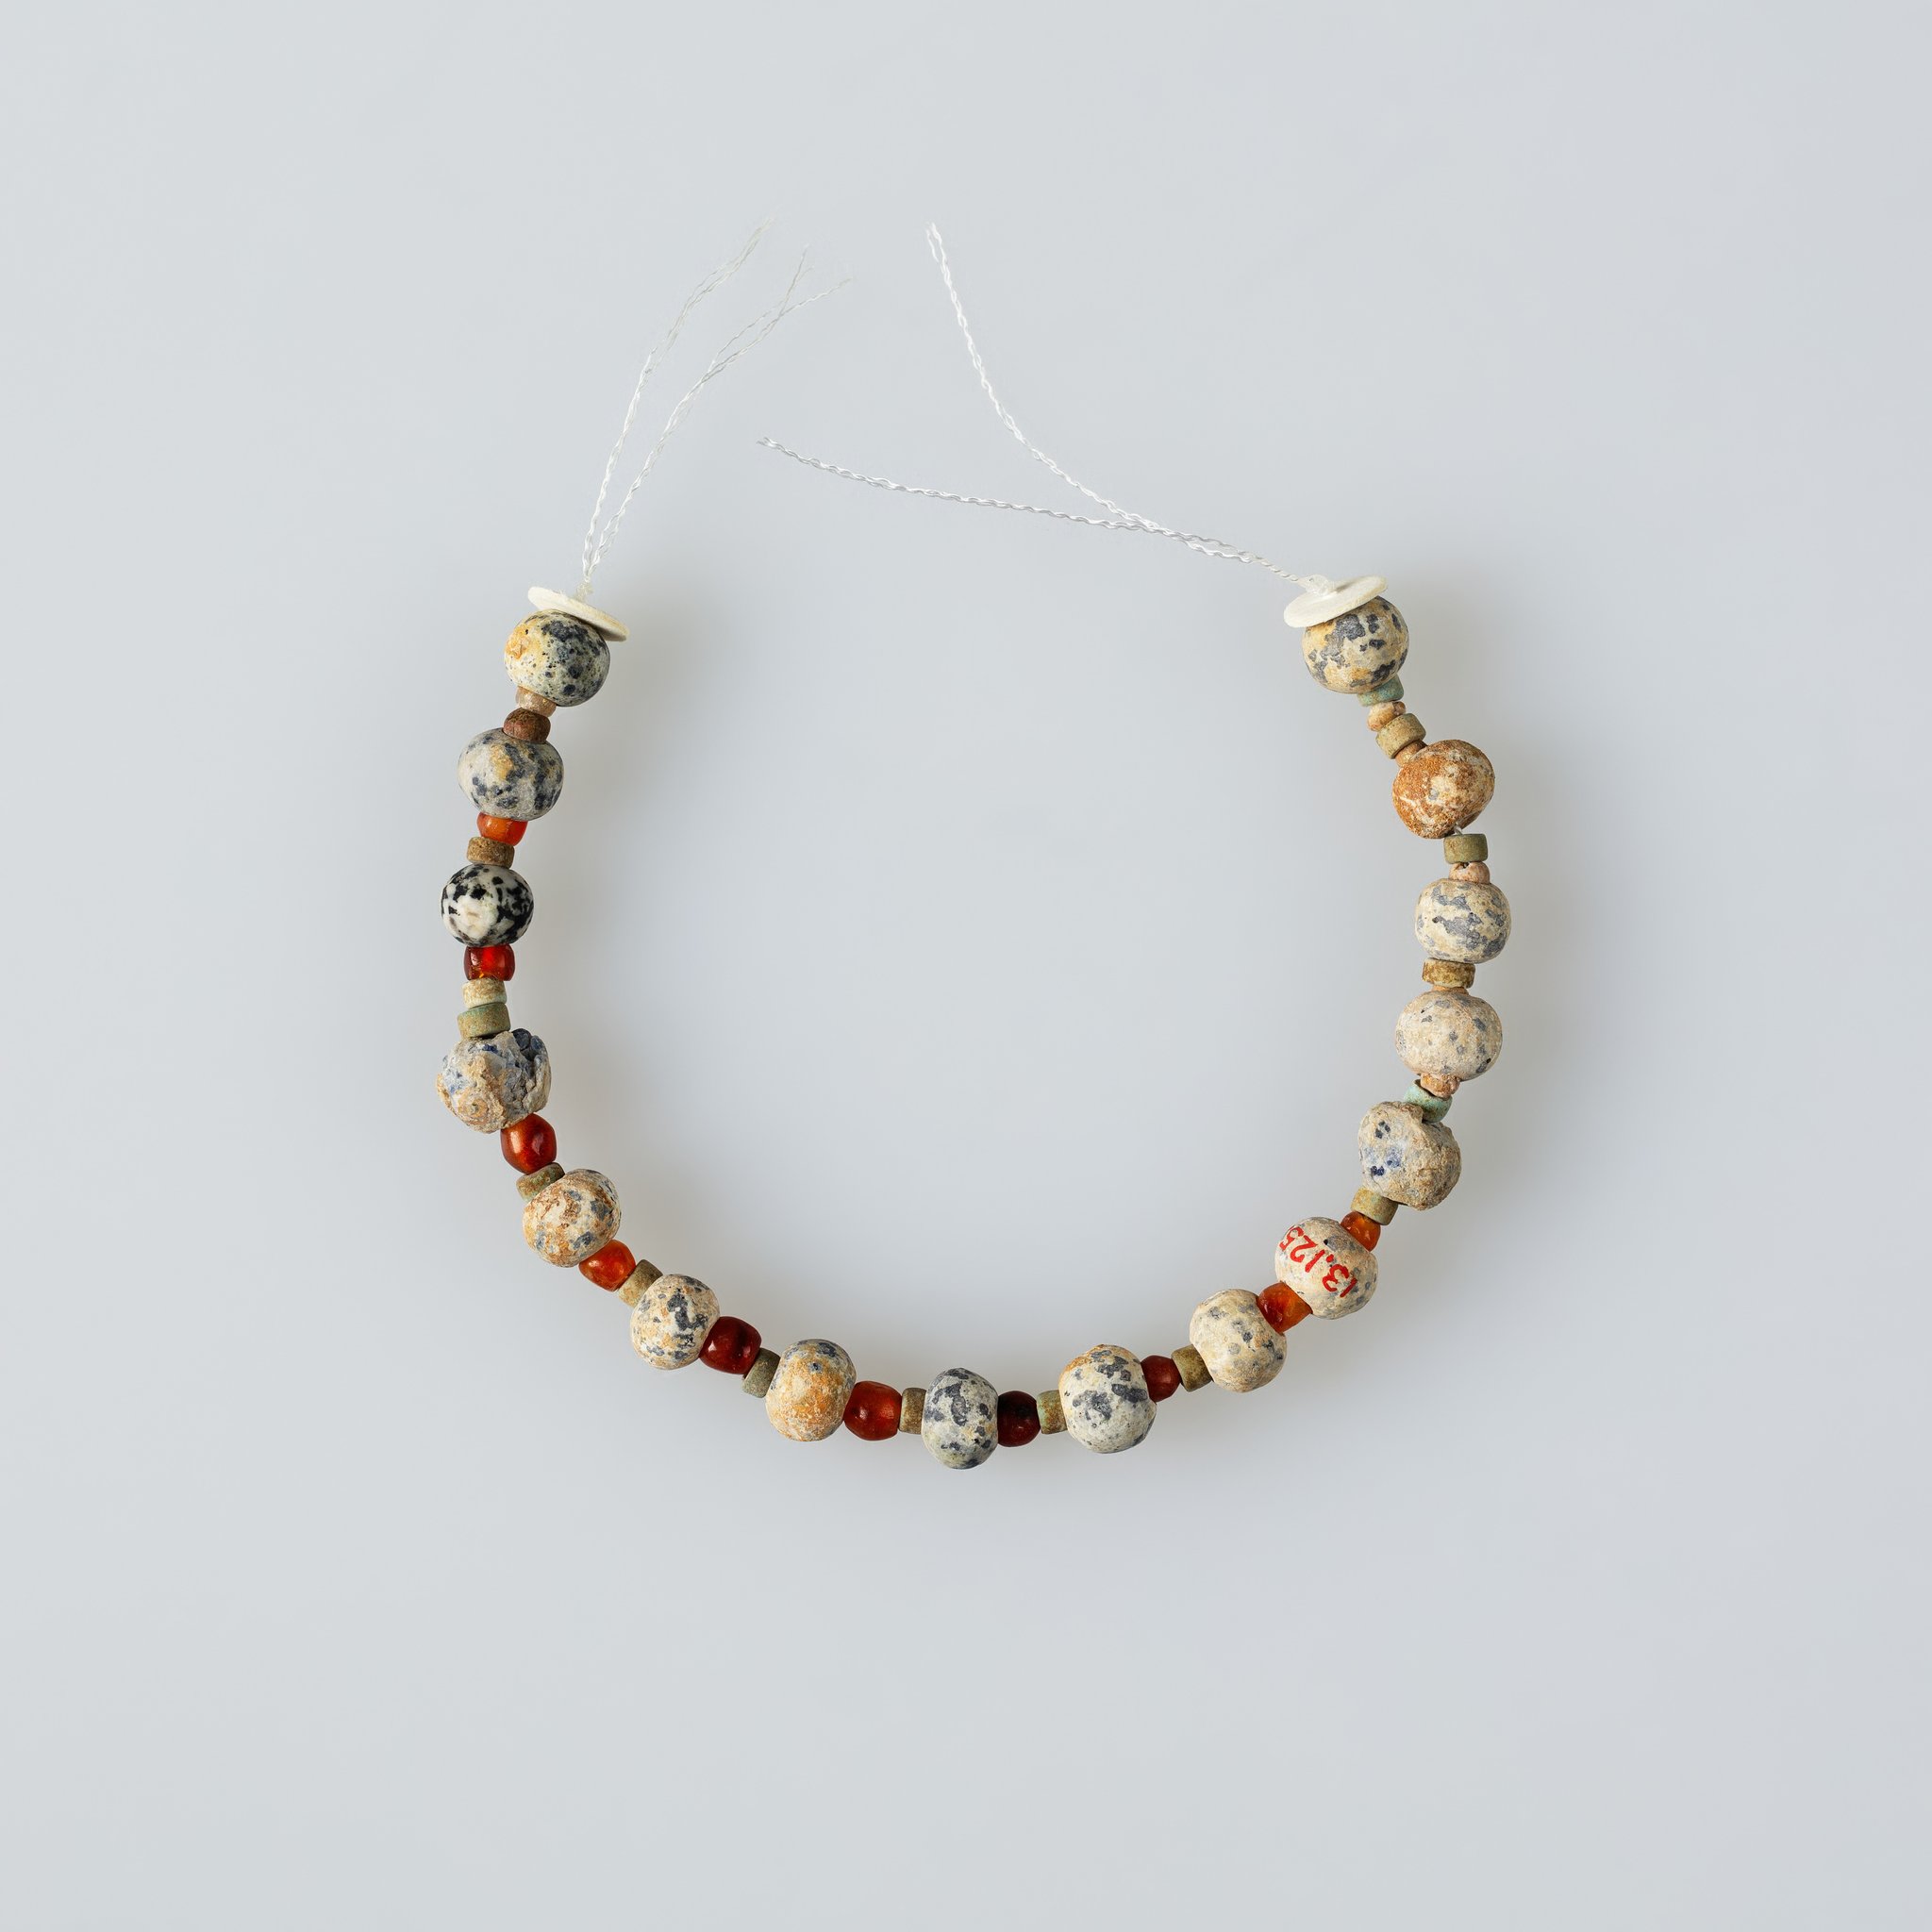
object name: bead, string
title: String of beads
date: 30 BCE-364 CE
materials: gemstone, glass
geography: nubia